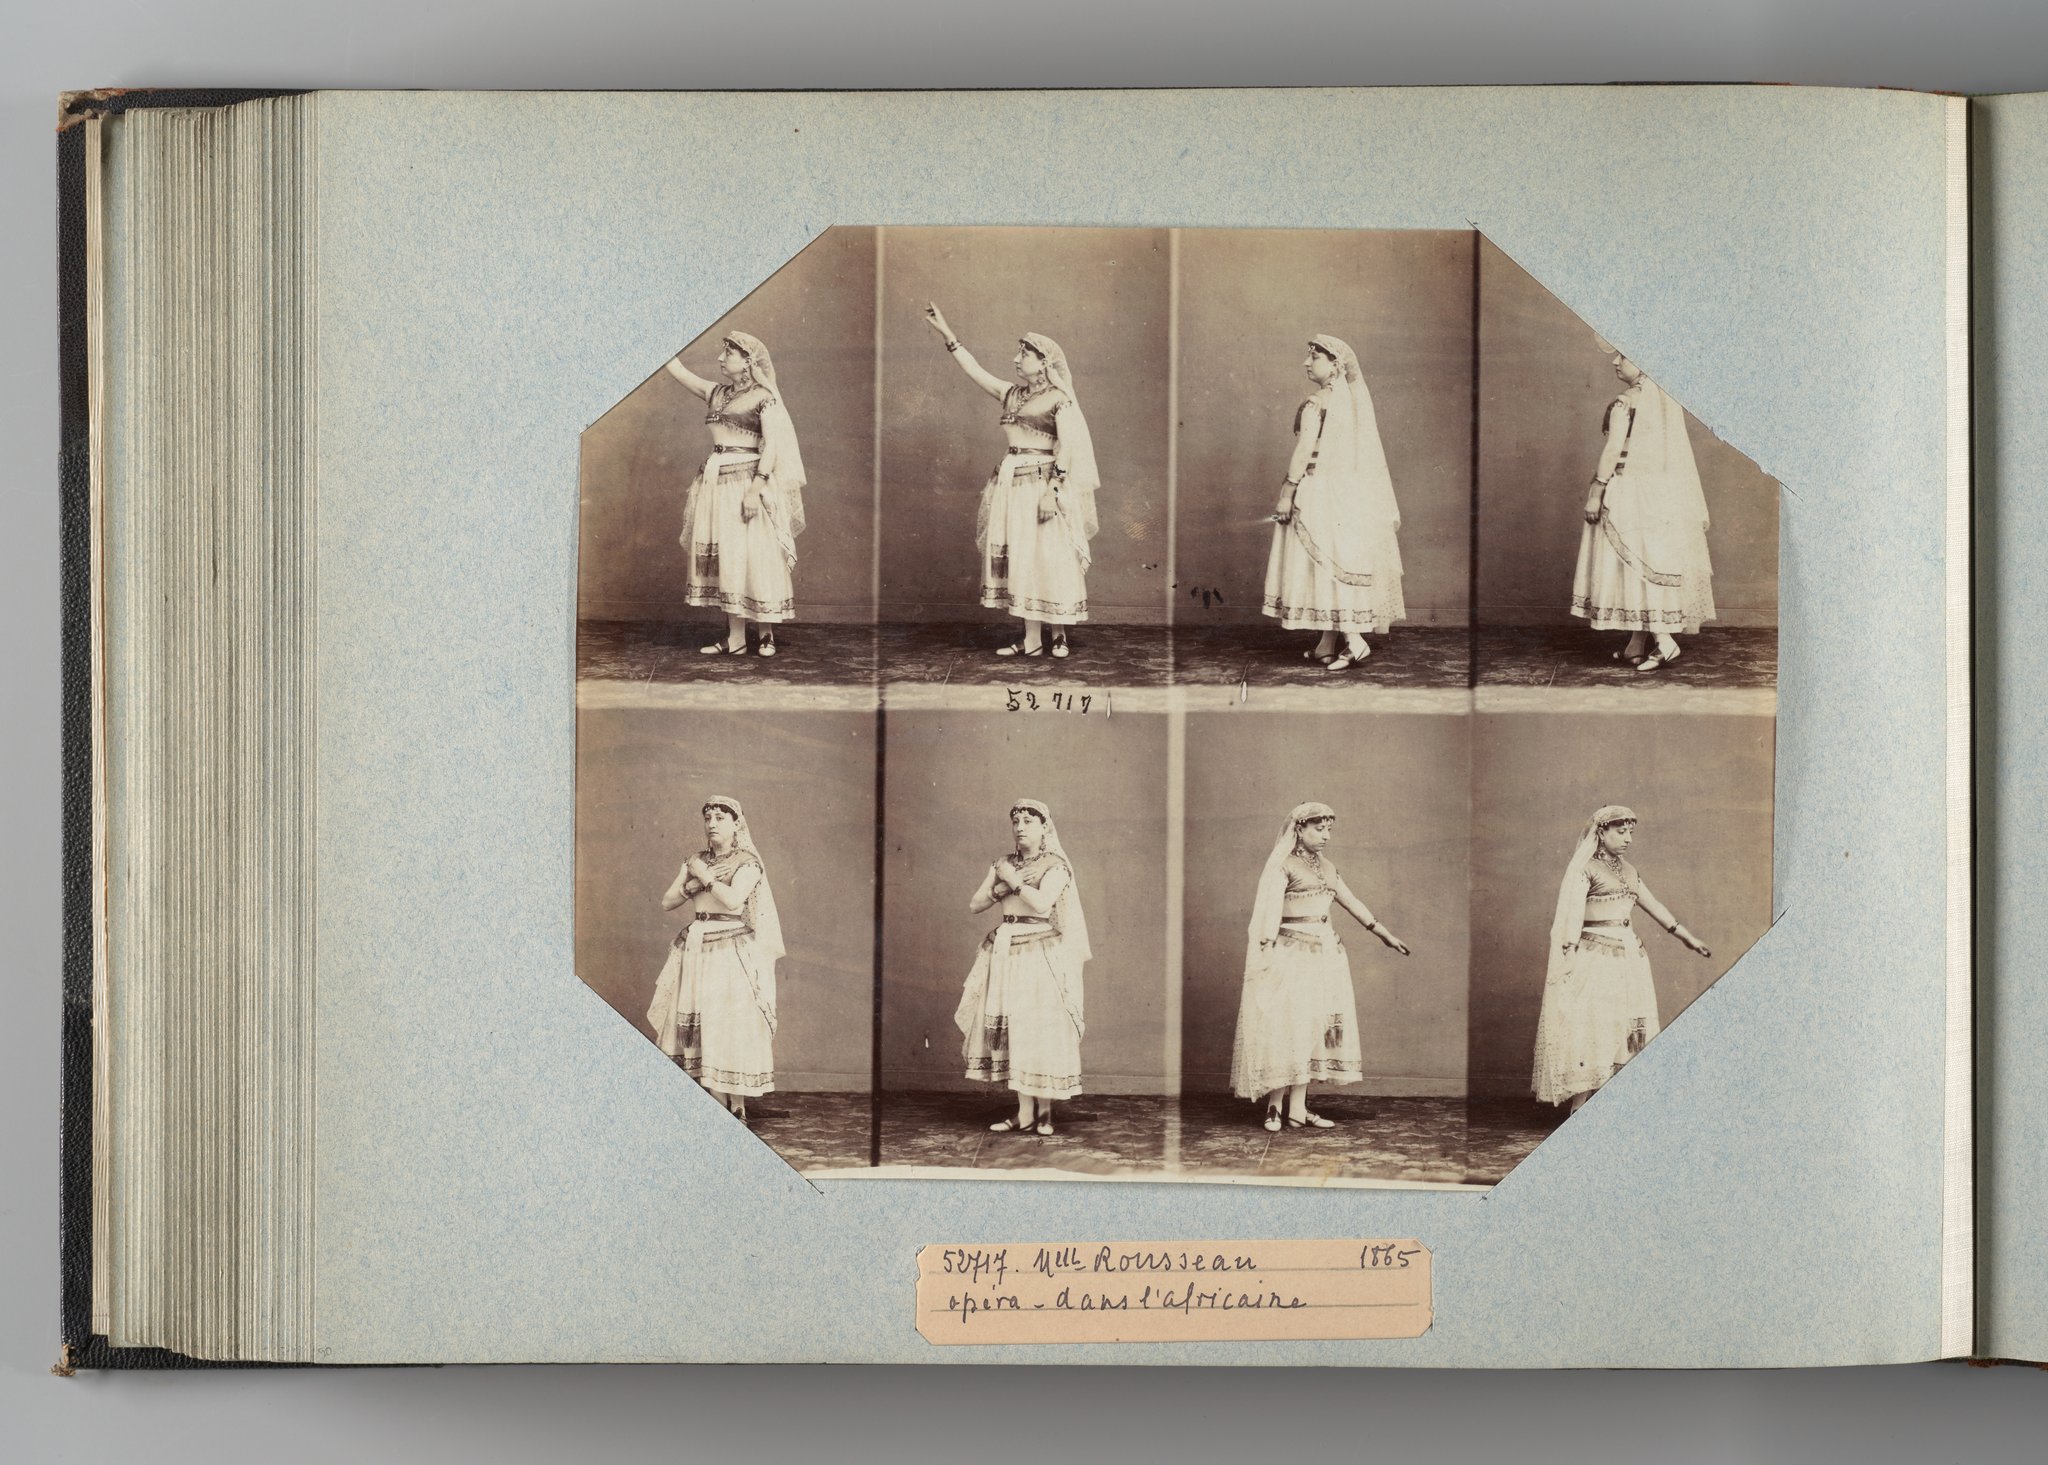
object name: photograph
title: Mlle Rousseau dans l'Africaine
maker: andré-adolphe-eugène disdéri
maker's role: artist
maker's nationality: french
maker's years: 1819-1889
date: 1865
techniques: albumen silver print, glass negative